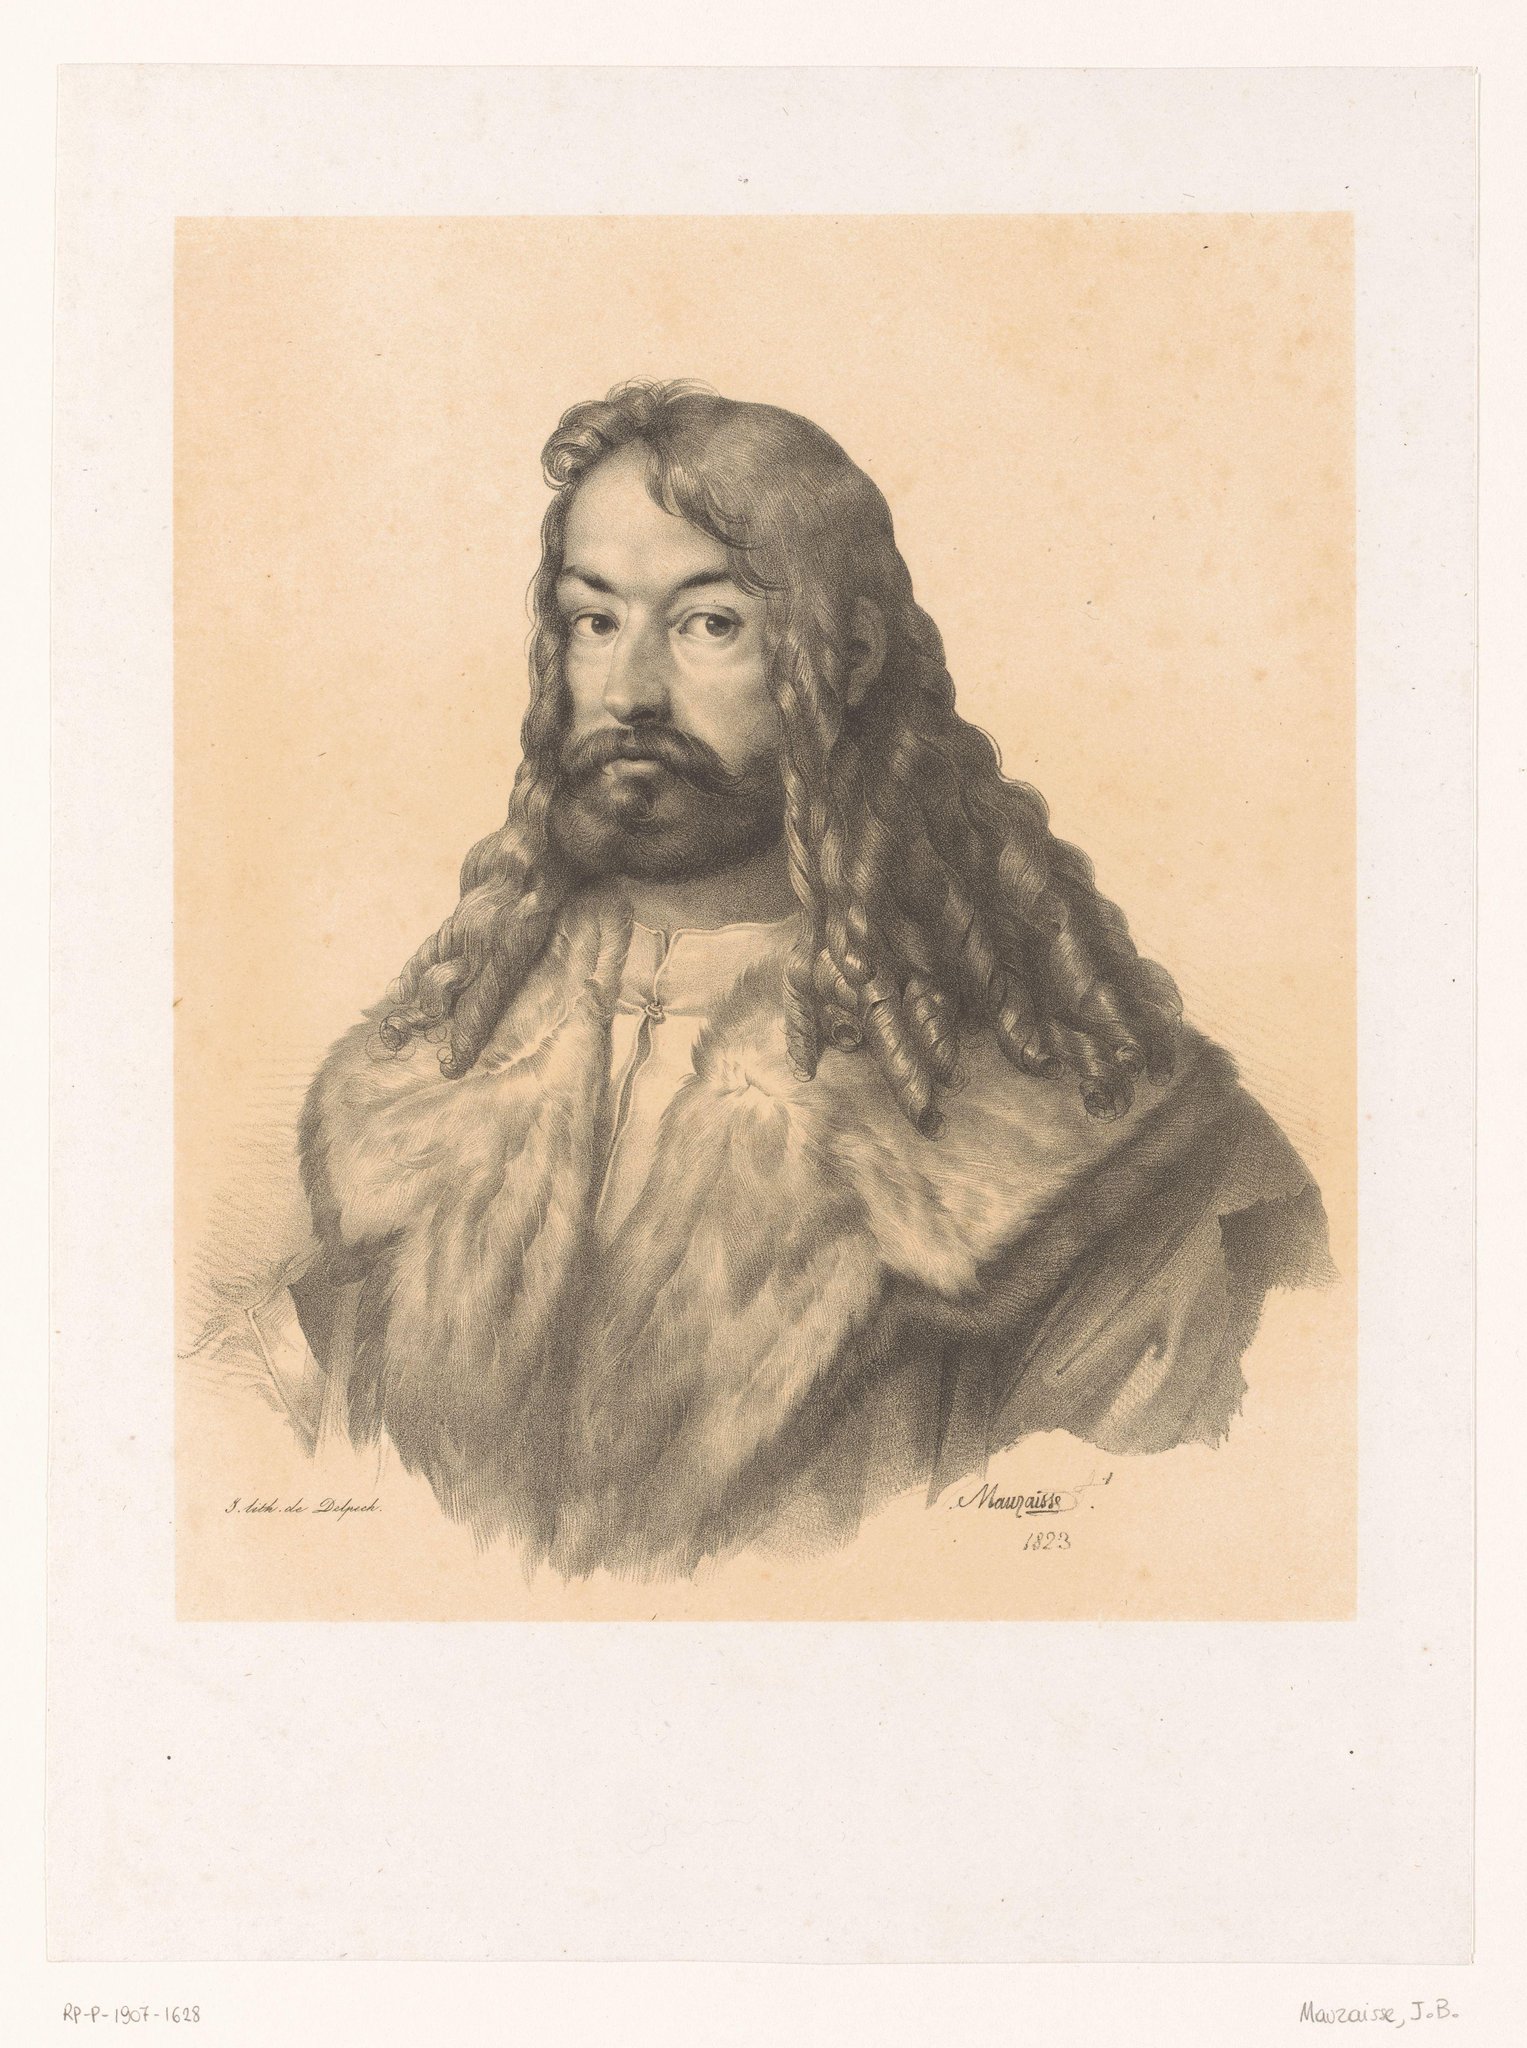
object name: print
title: Portret van een man met baard, mogelijk een schilder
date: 1823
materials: paper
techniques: tone lithography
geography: paris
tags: historical persons, beard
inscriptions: collector's mark: Lugt 2228